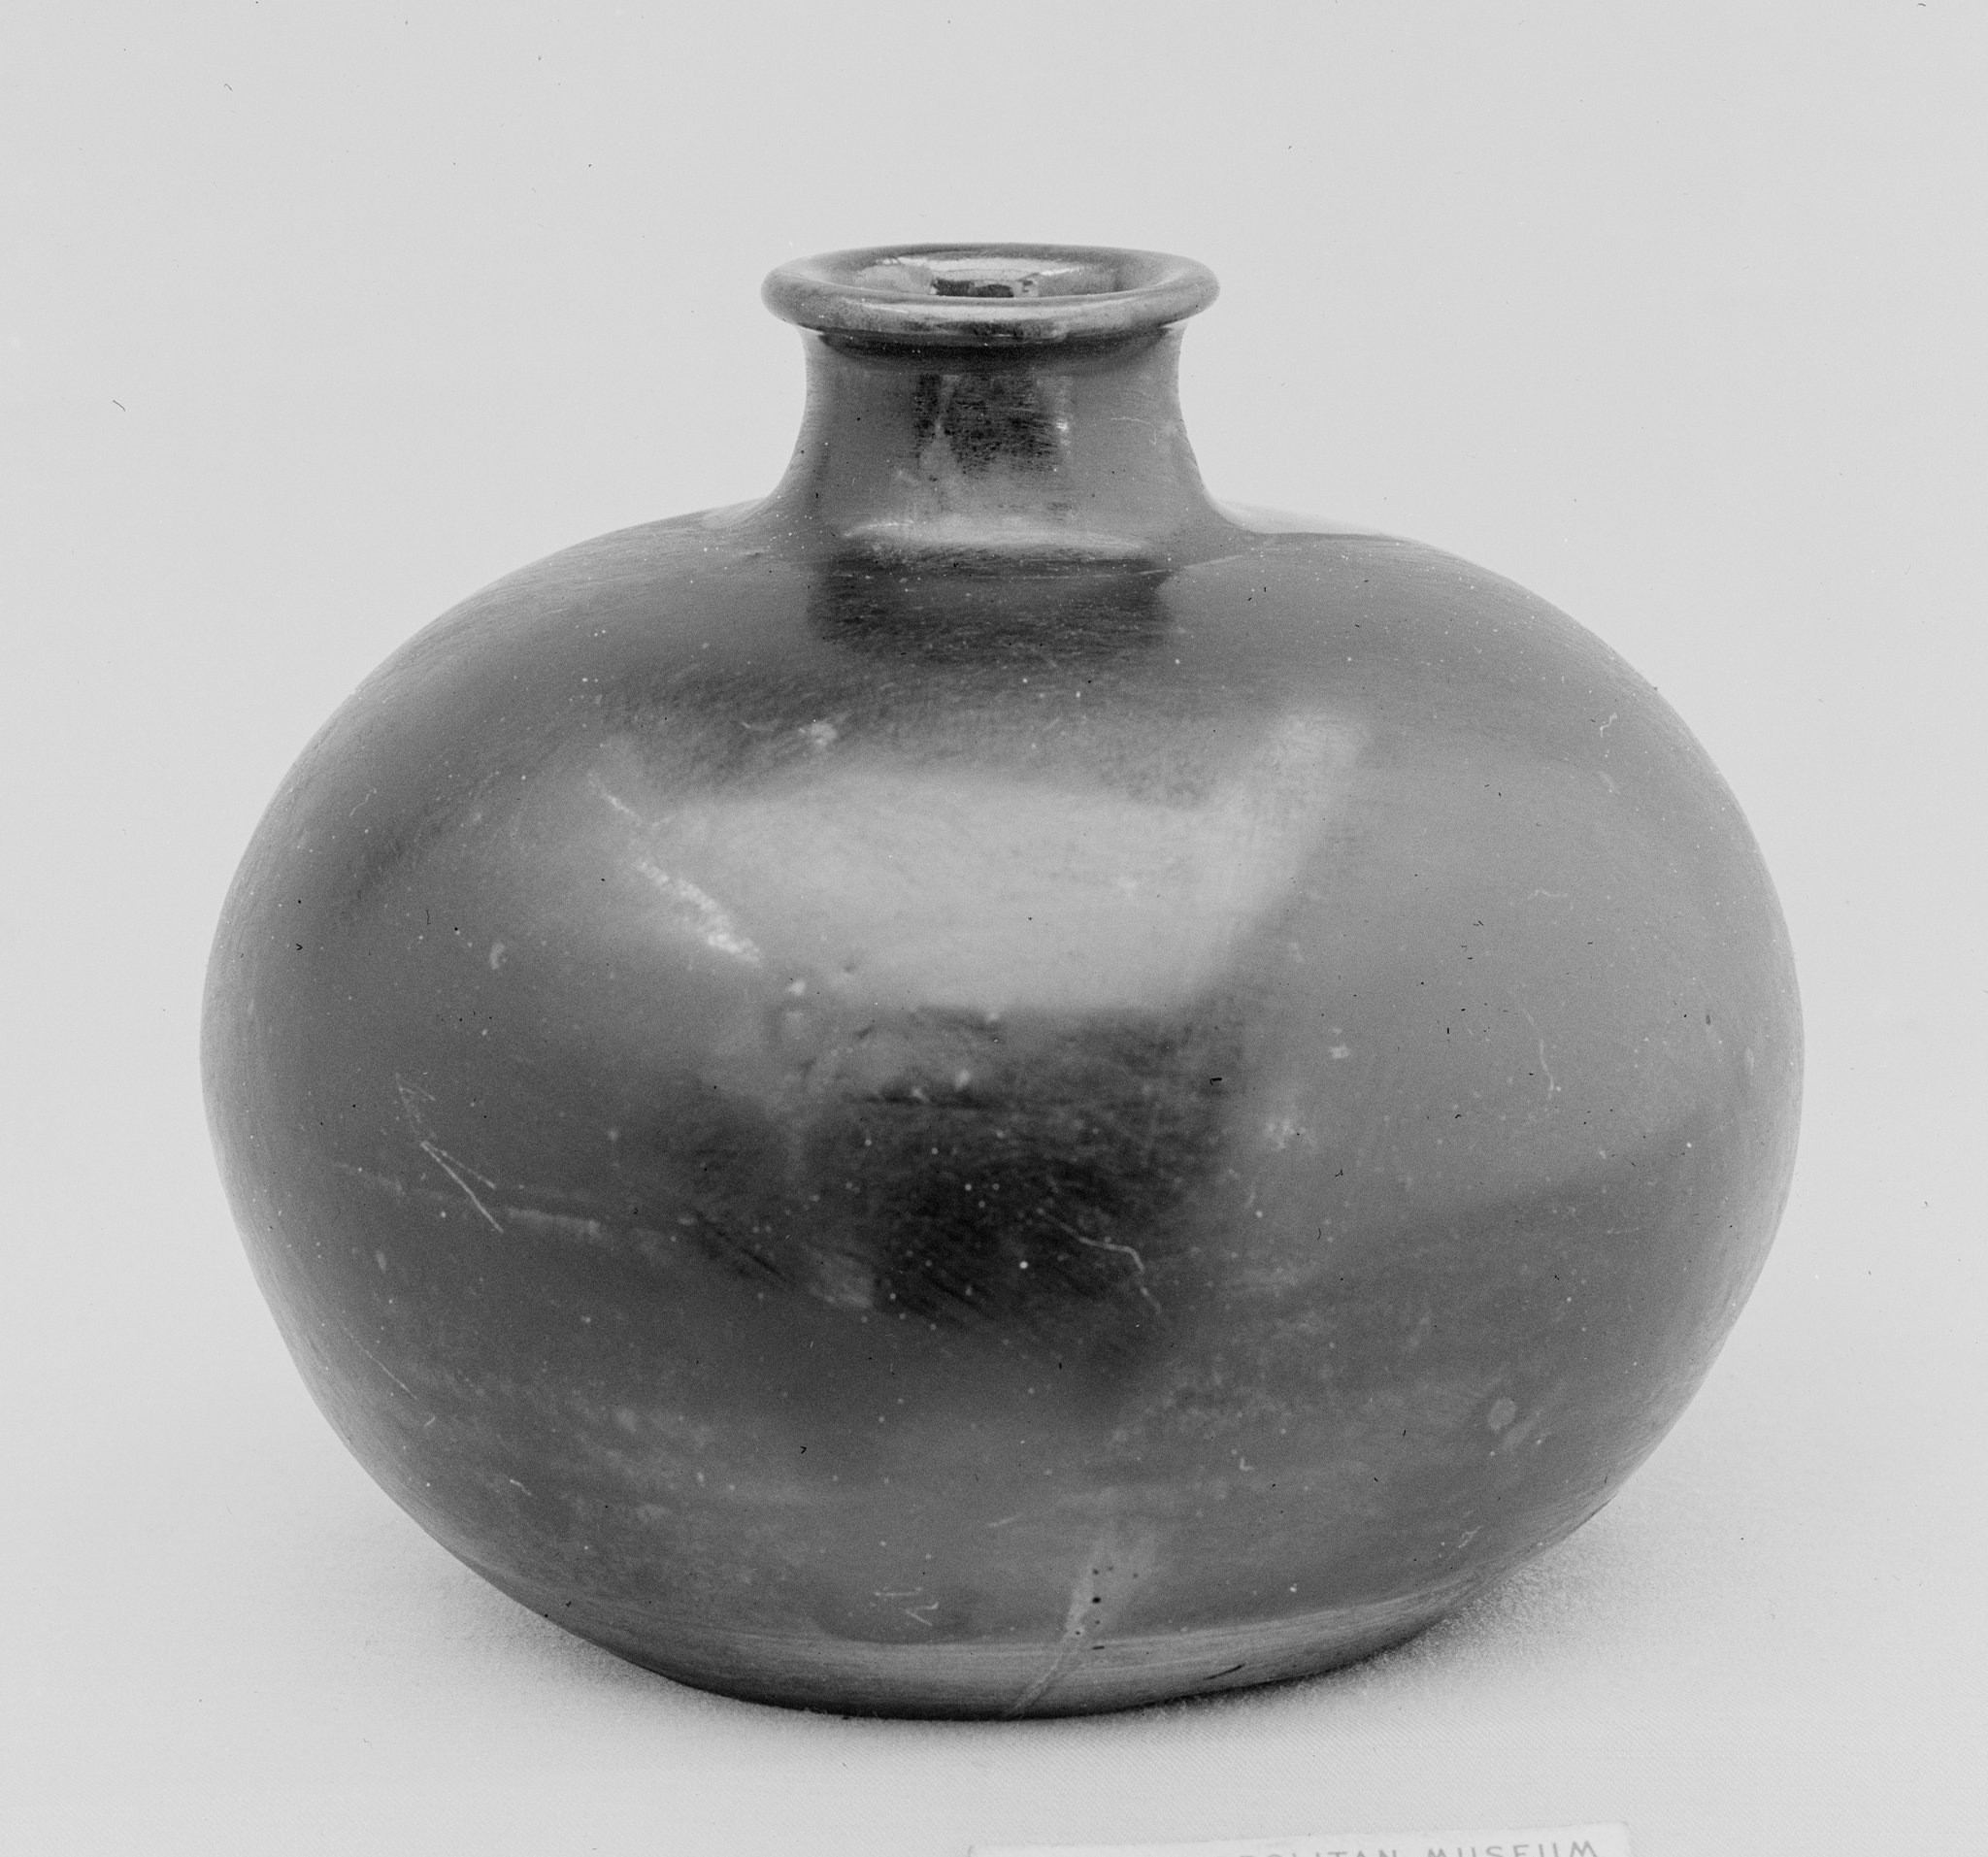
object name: bottle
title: Bottle For Sweets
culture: japanese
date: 1701-1800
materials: clay